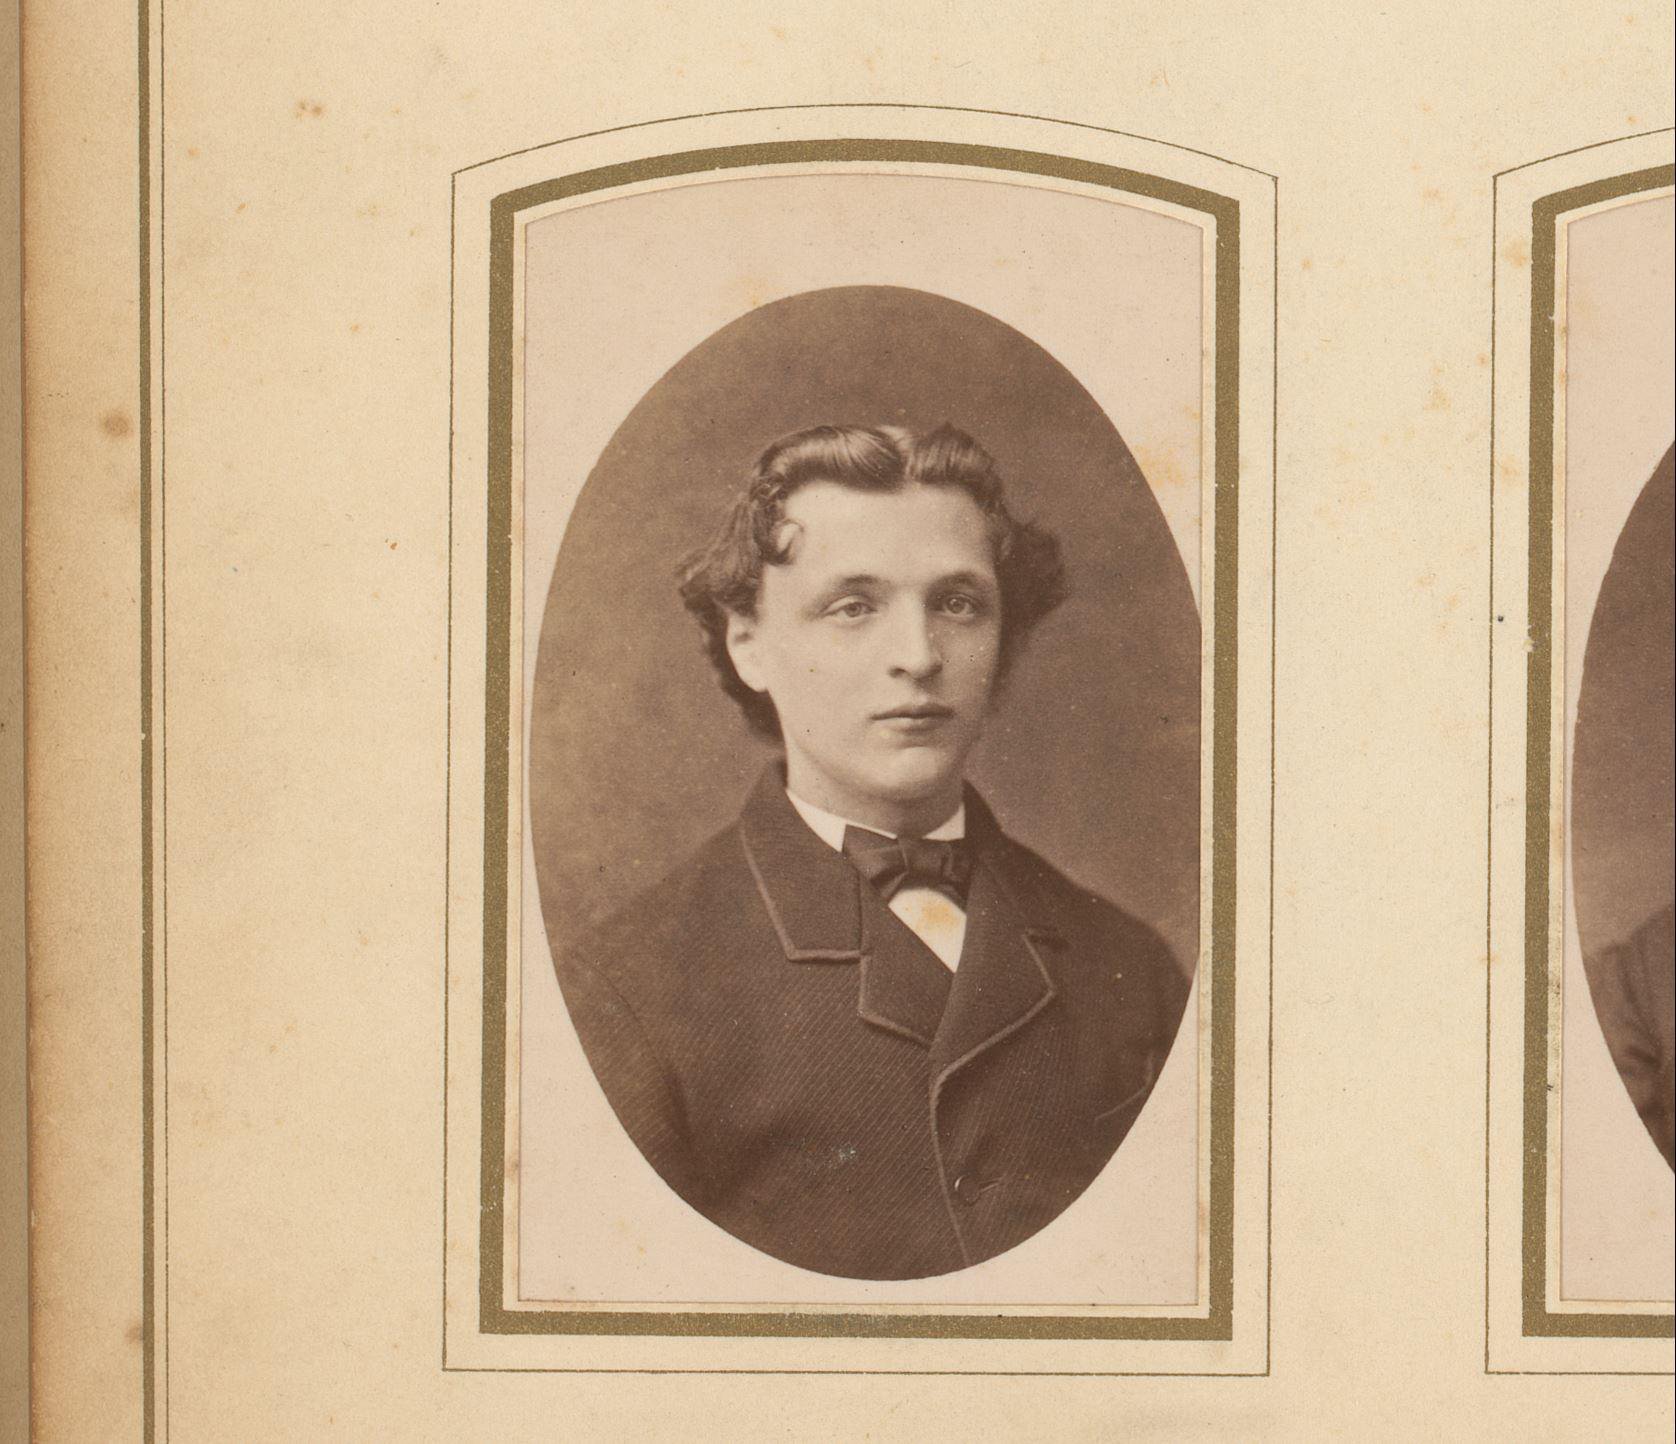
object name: photograph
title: Portret van een man met vlinderstrik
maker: thomas martin staas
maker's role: fotograaf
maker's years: 1844-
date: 1865-1895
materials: cardboard, photographic support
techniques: albumen print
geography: leeuwarden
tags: historical persons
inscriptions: inscription: ‘Th. M. Staas/ Photograaf van Z.M. den Koning der Nederlanden/ Firma: E. Fuchs/ Leeuwarden/ Willemskade Zuidzijde Let. L 285./ Voor nabestellingen en vergootingen/ worden alle negatieven bewaard.’